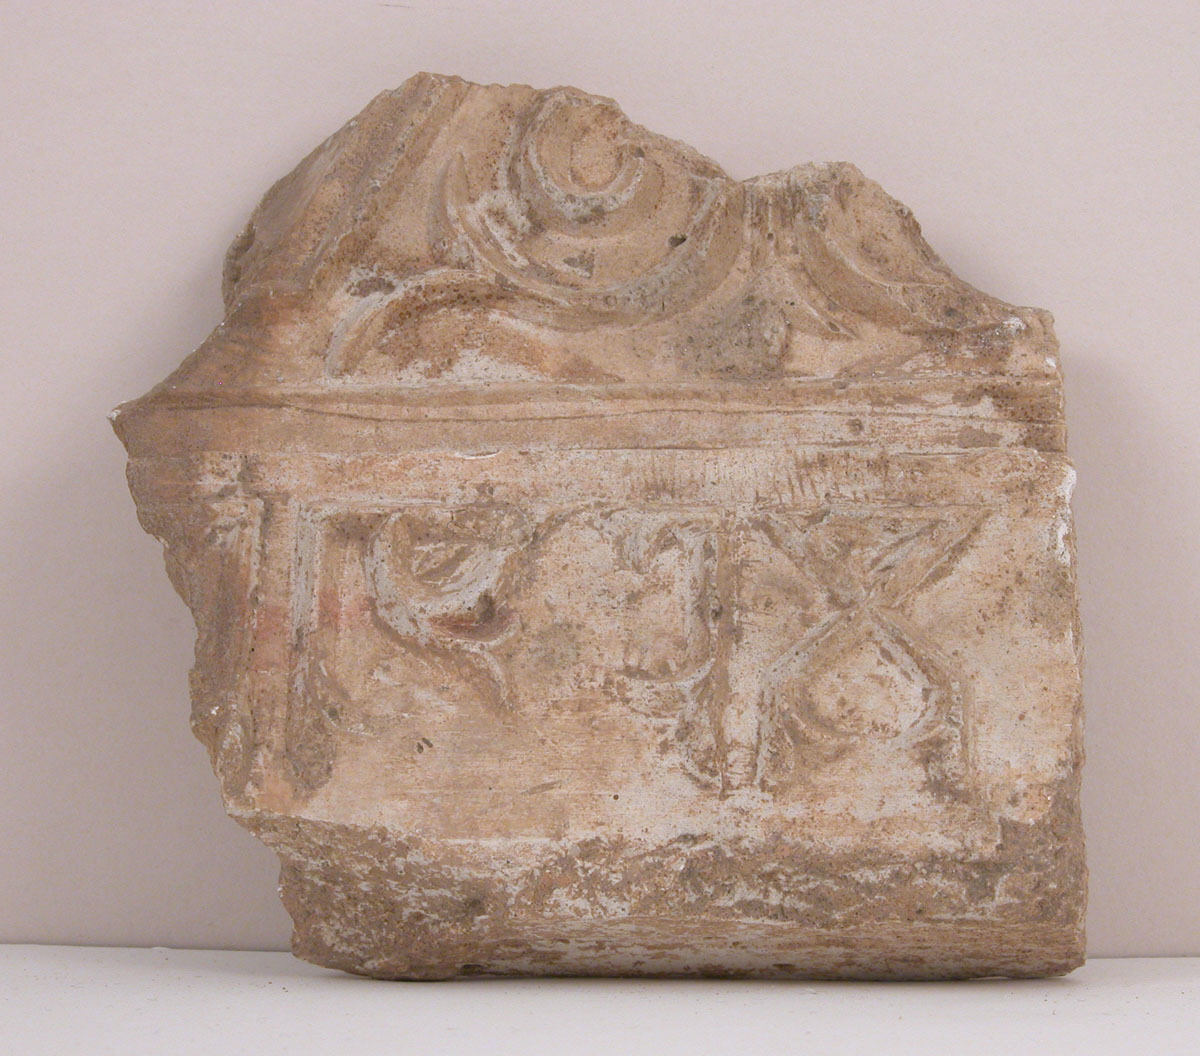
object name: fragment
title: Window Frame Fragment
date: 701-1300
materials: plaster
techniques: molding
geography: iran